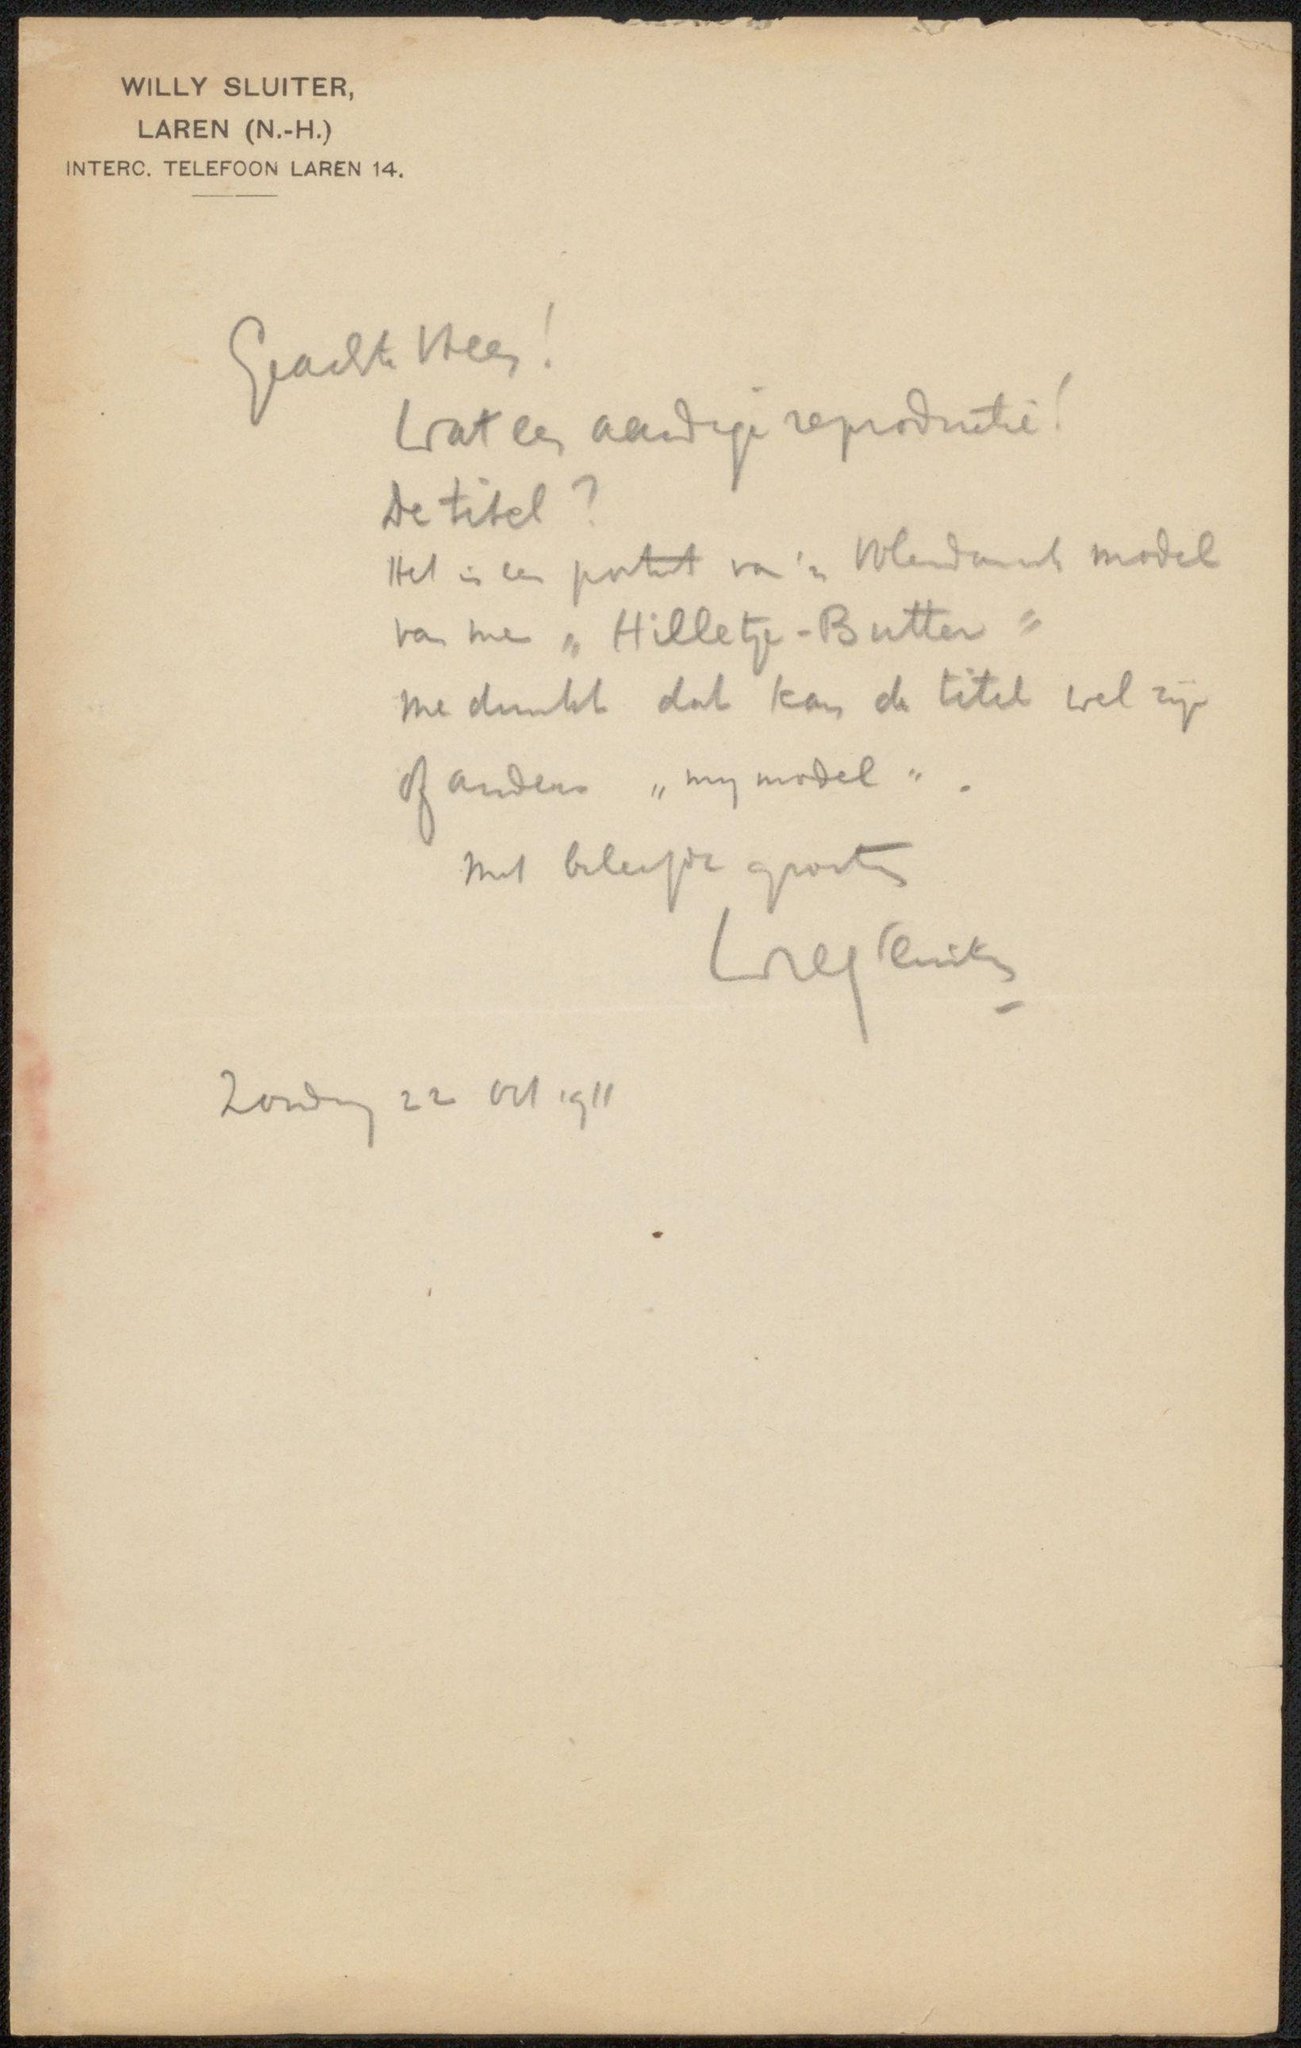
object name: letter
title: Brief aan Philip Zilcken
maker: willy sluiter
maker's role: draughtsman, painter, print maker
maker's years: 1873-1949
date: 1911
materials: paper, pencil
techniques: printing, writing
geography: laren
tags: the hague, painter, draughtsman, philip zilcken, historical persons (portraits and scenes from the life)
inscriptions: collector's mark: ‘RPK’, watermark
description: De envelop is genummerd "bij Moes (Wally): 182".